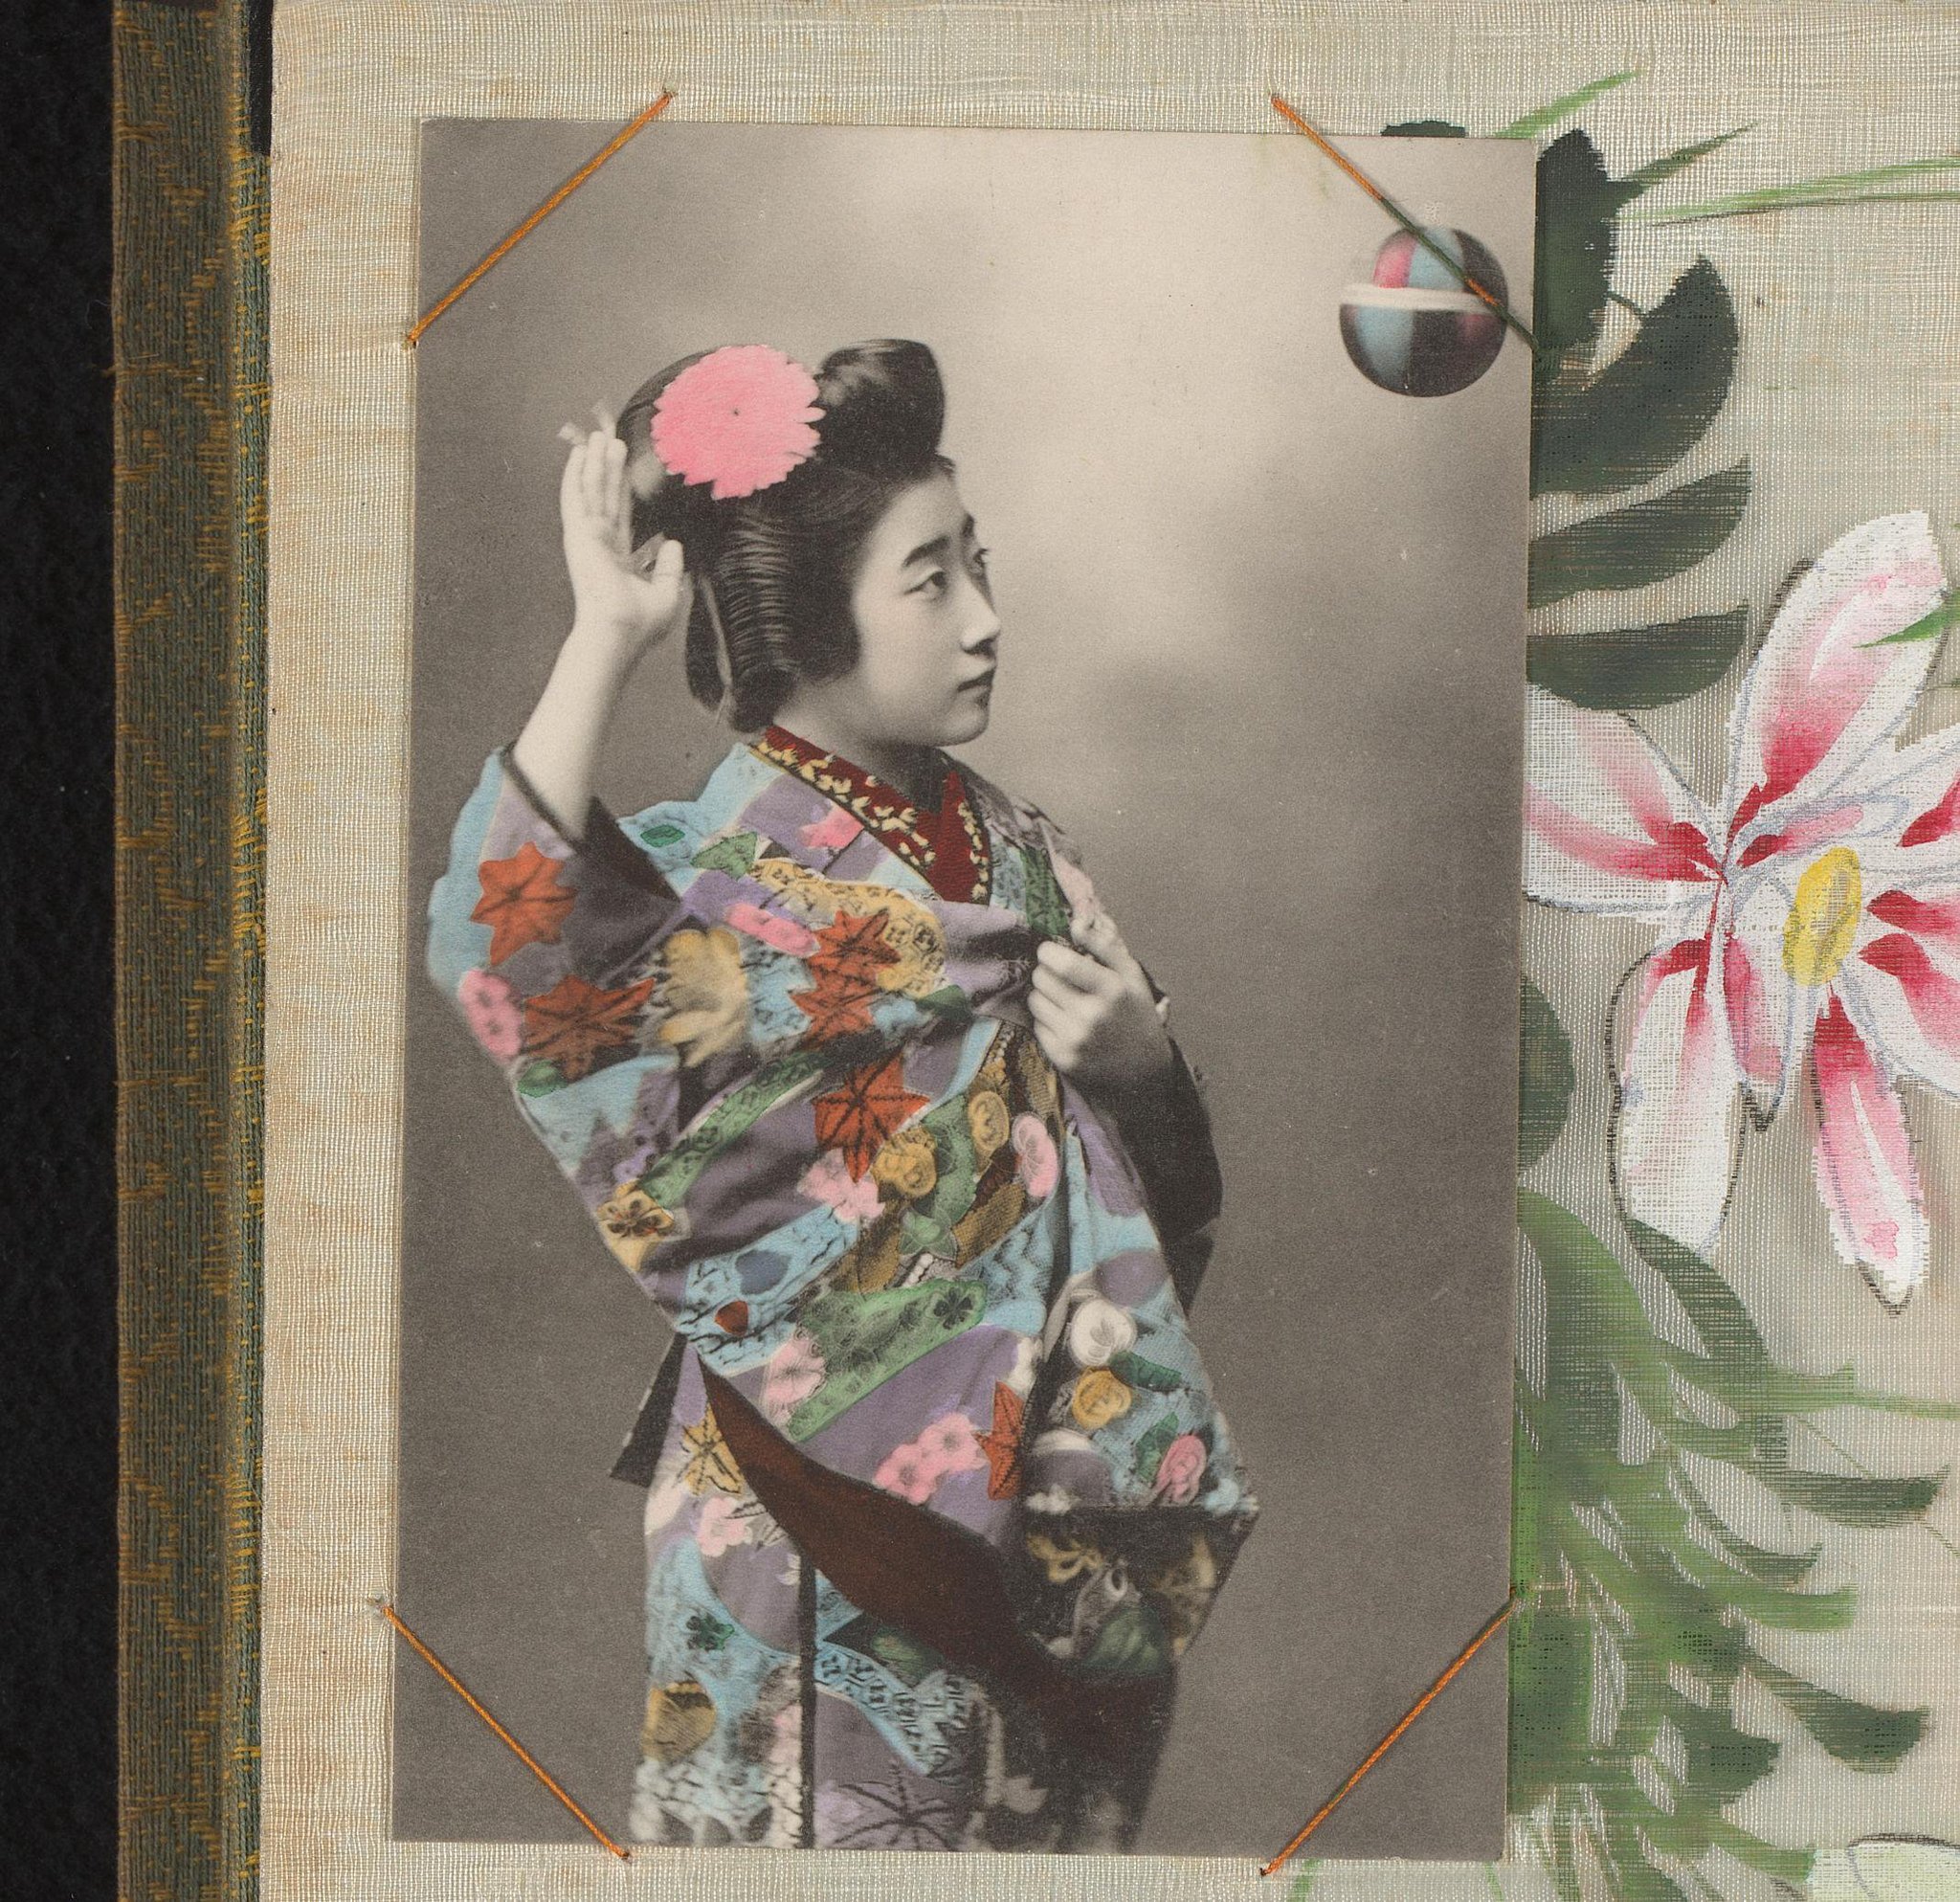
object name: ansichtkaart, prentbriefkaart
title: Japanse vrouw in gekleurde kimono met bloem in het haar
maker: Anonymous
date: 1900-1920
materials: paper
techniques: photograph, hand coloring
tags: historical persons - bb - woman, folk costume, regional costume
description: Deze prent maakt deel uit van een album.